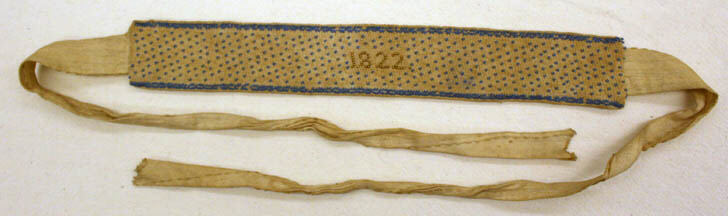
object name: garter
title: Garters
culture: european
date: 1822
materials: cotton